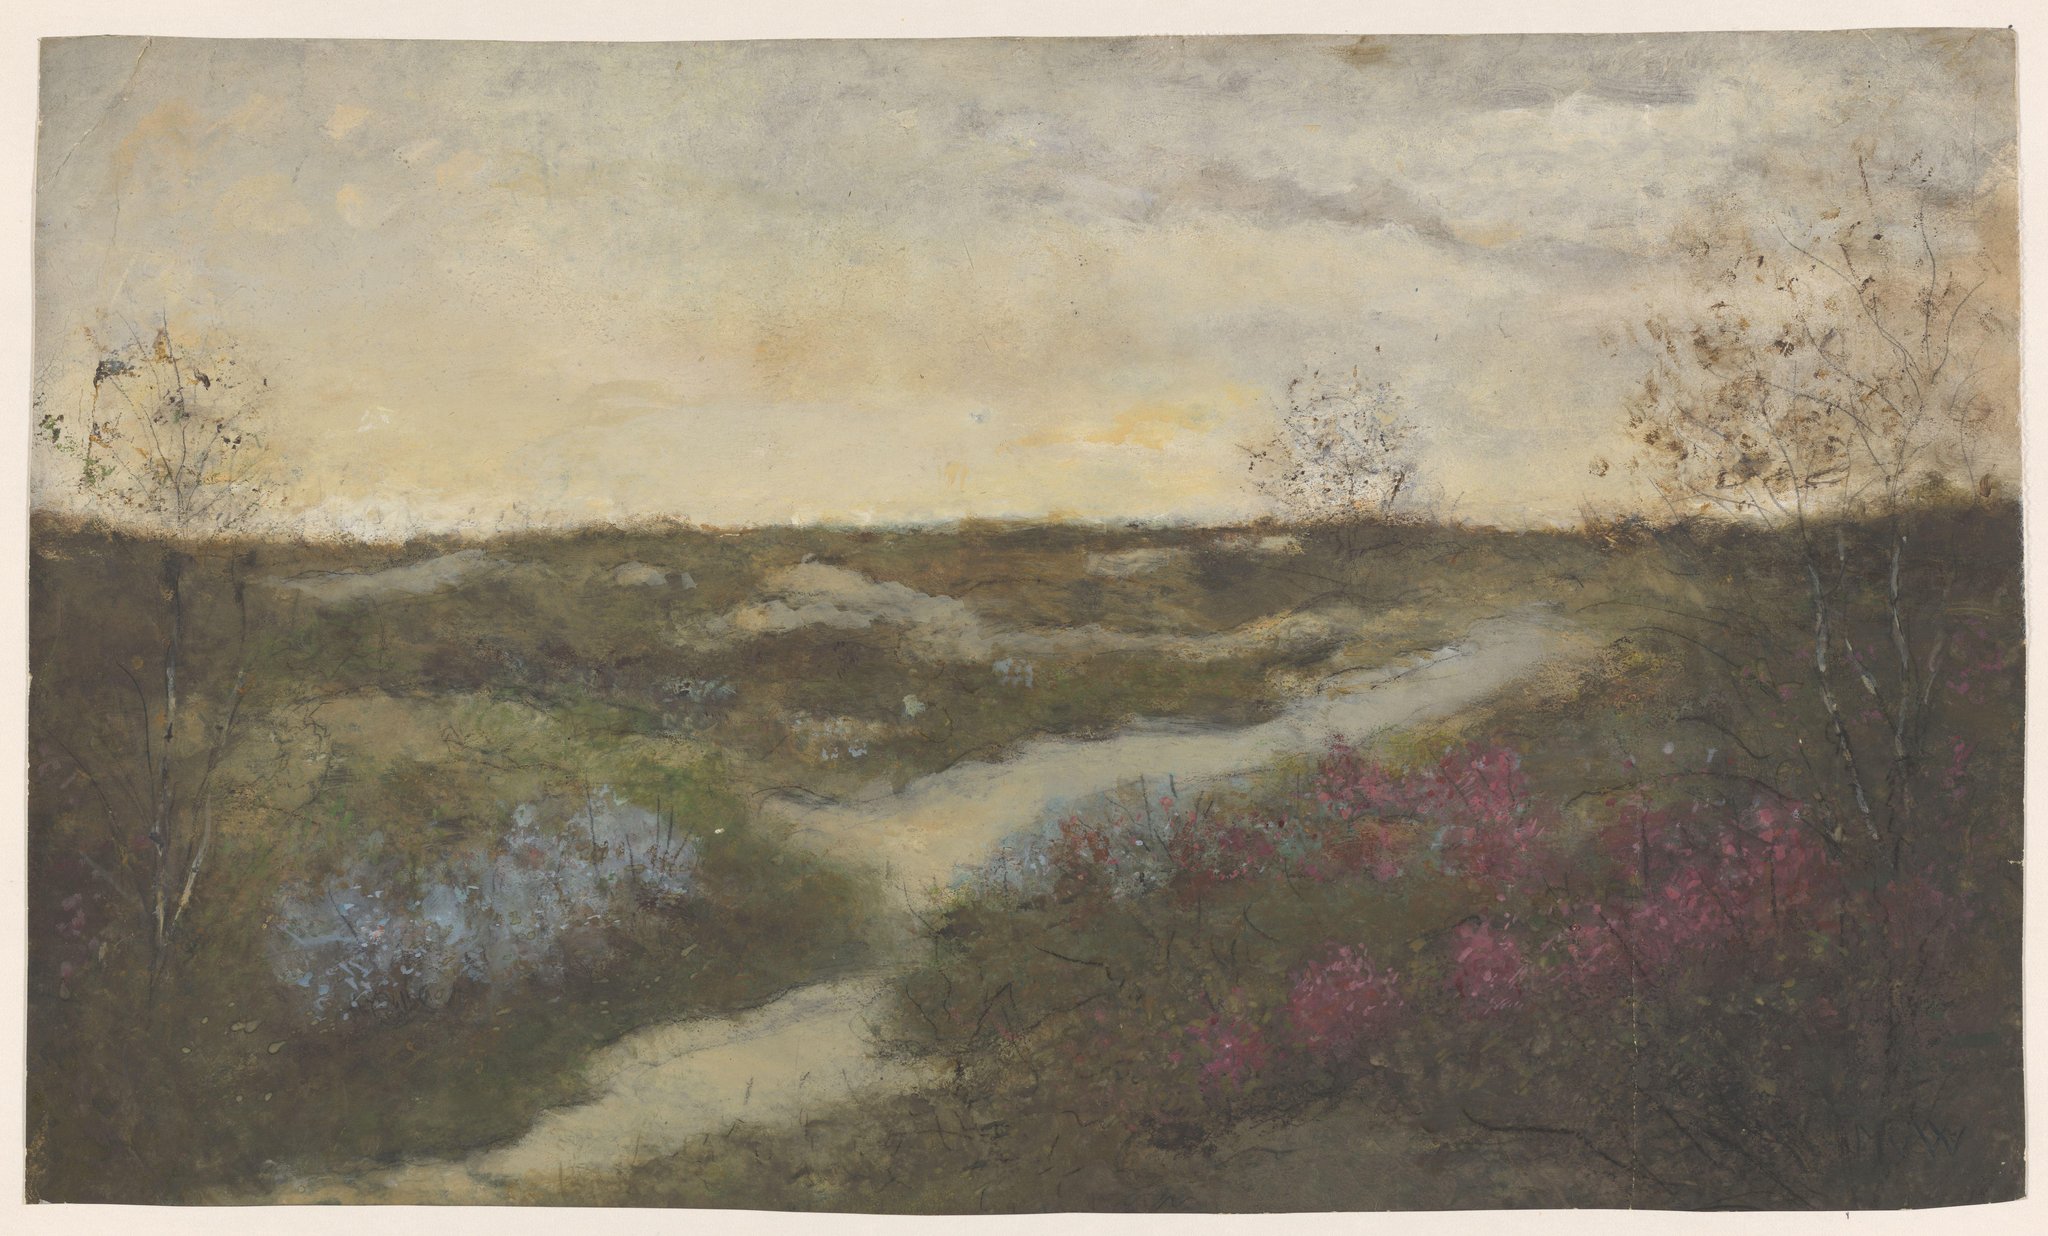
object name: drawing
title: Landschap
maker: Anonymous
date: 1800-1899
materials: chalk, paper, watercolor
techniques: brush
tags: landscapes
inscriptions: collector's mark: Lugt 2228